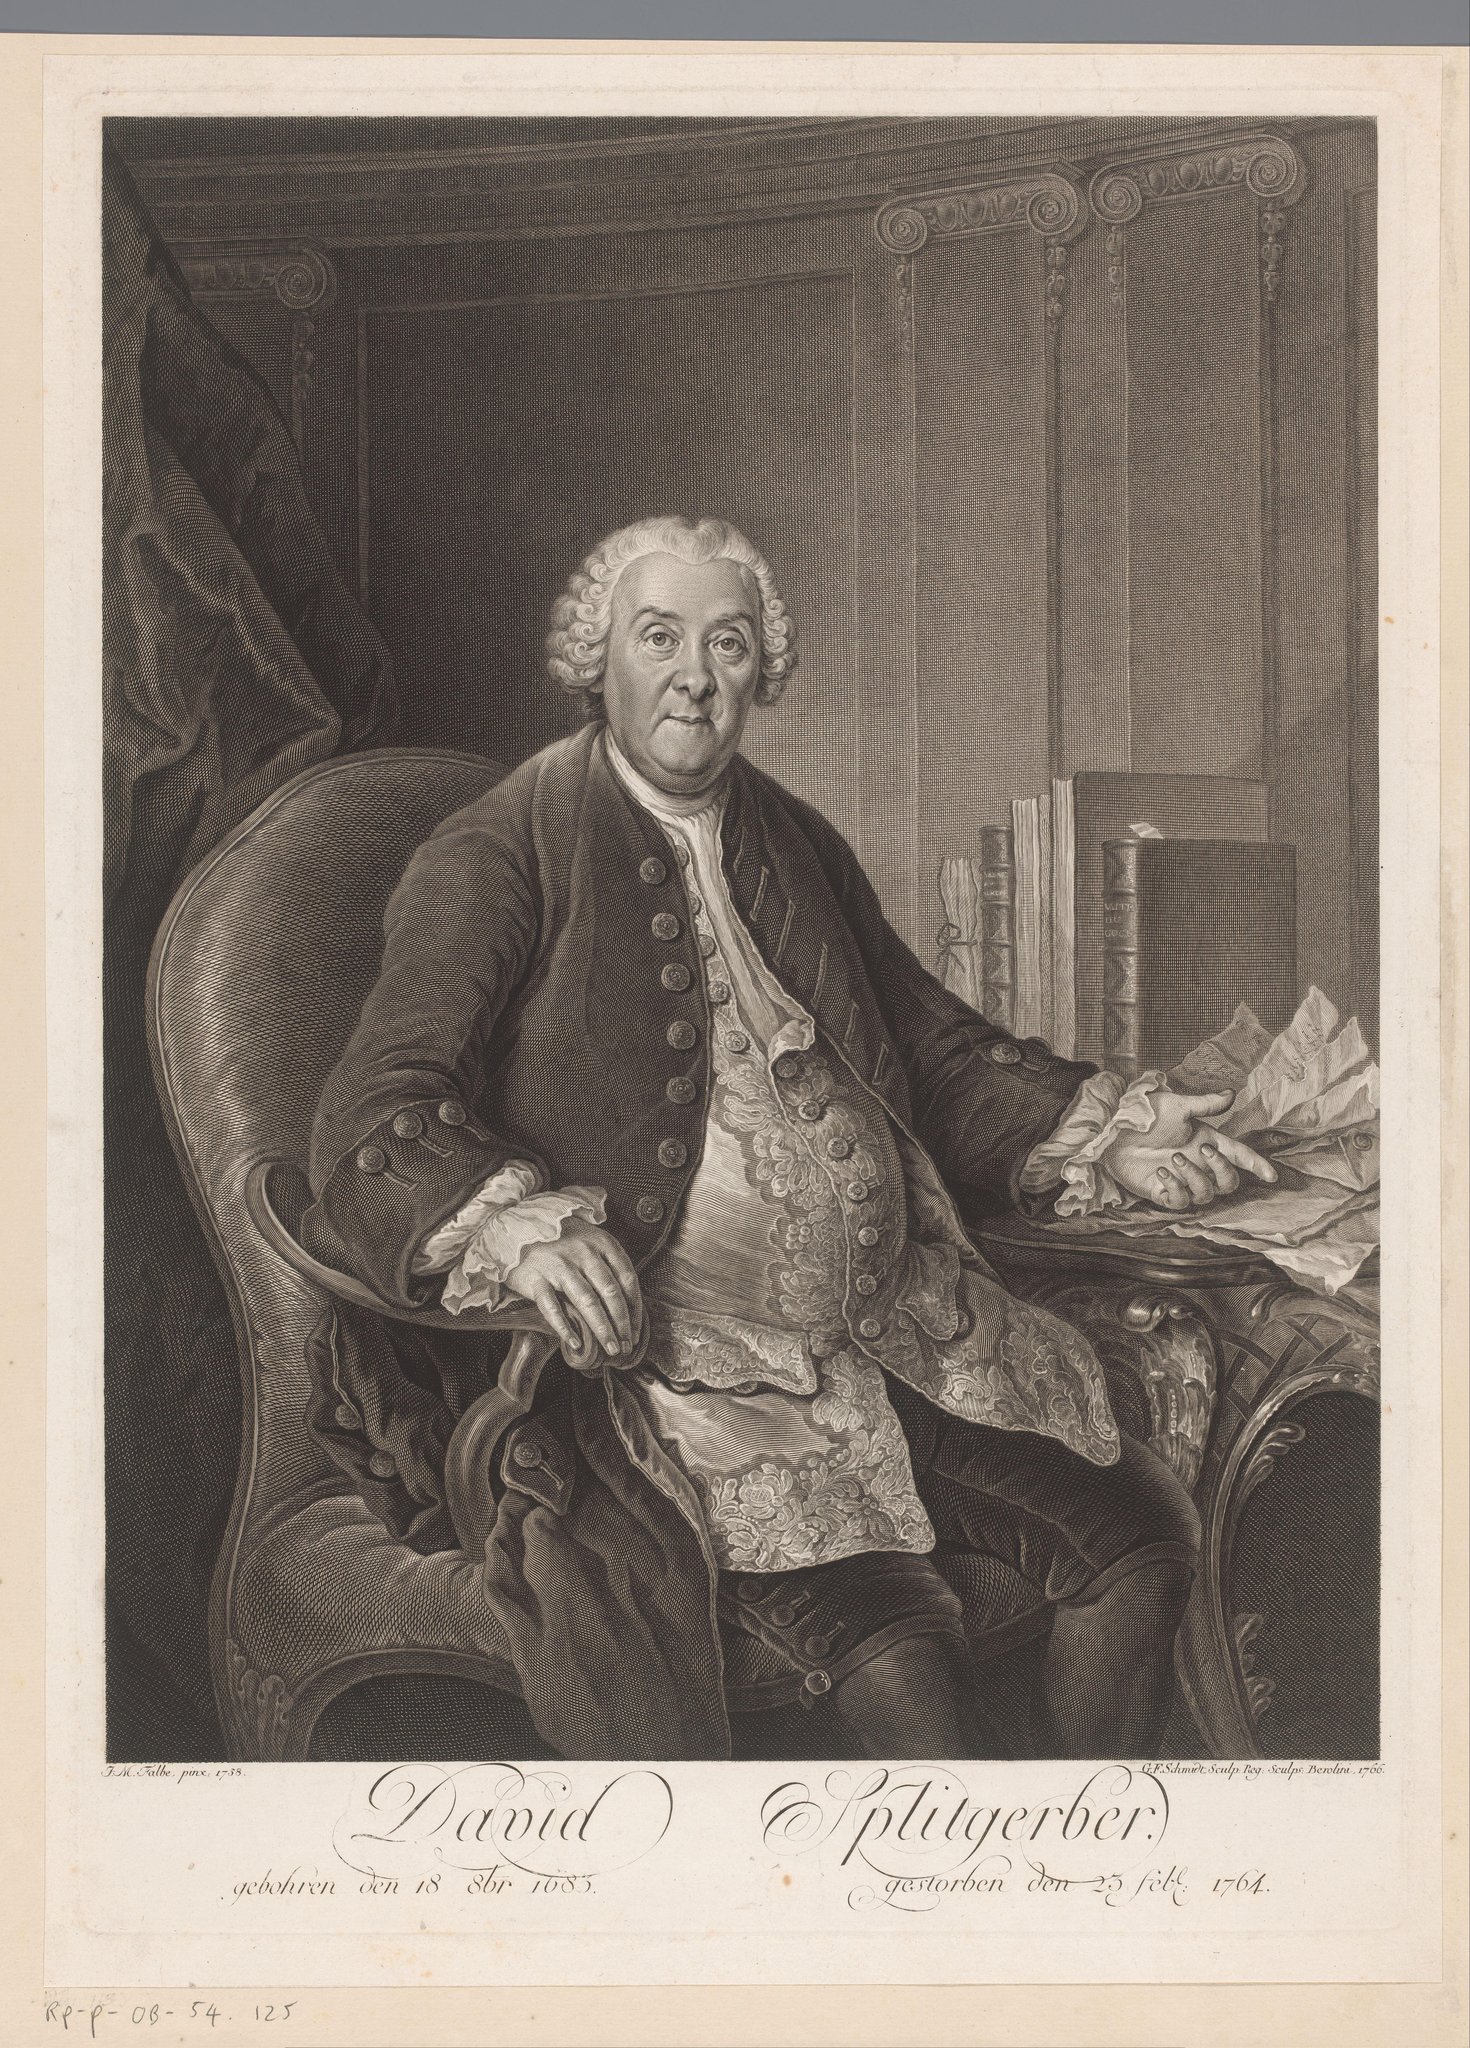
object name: print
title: Portret van David Splitgerber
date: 1766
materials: paper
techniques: engraving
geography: berlin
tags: berlin, historical persons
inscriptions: collector's mark: Lugt 240